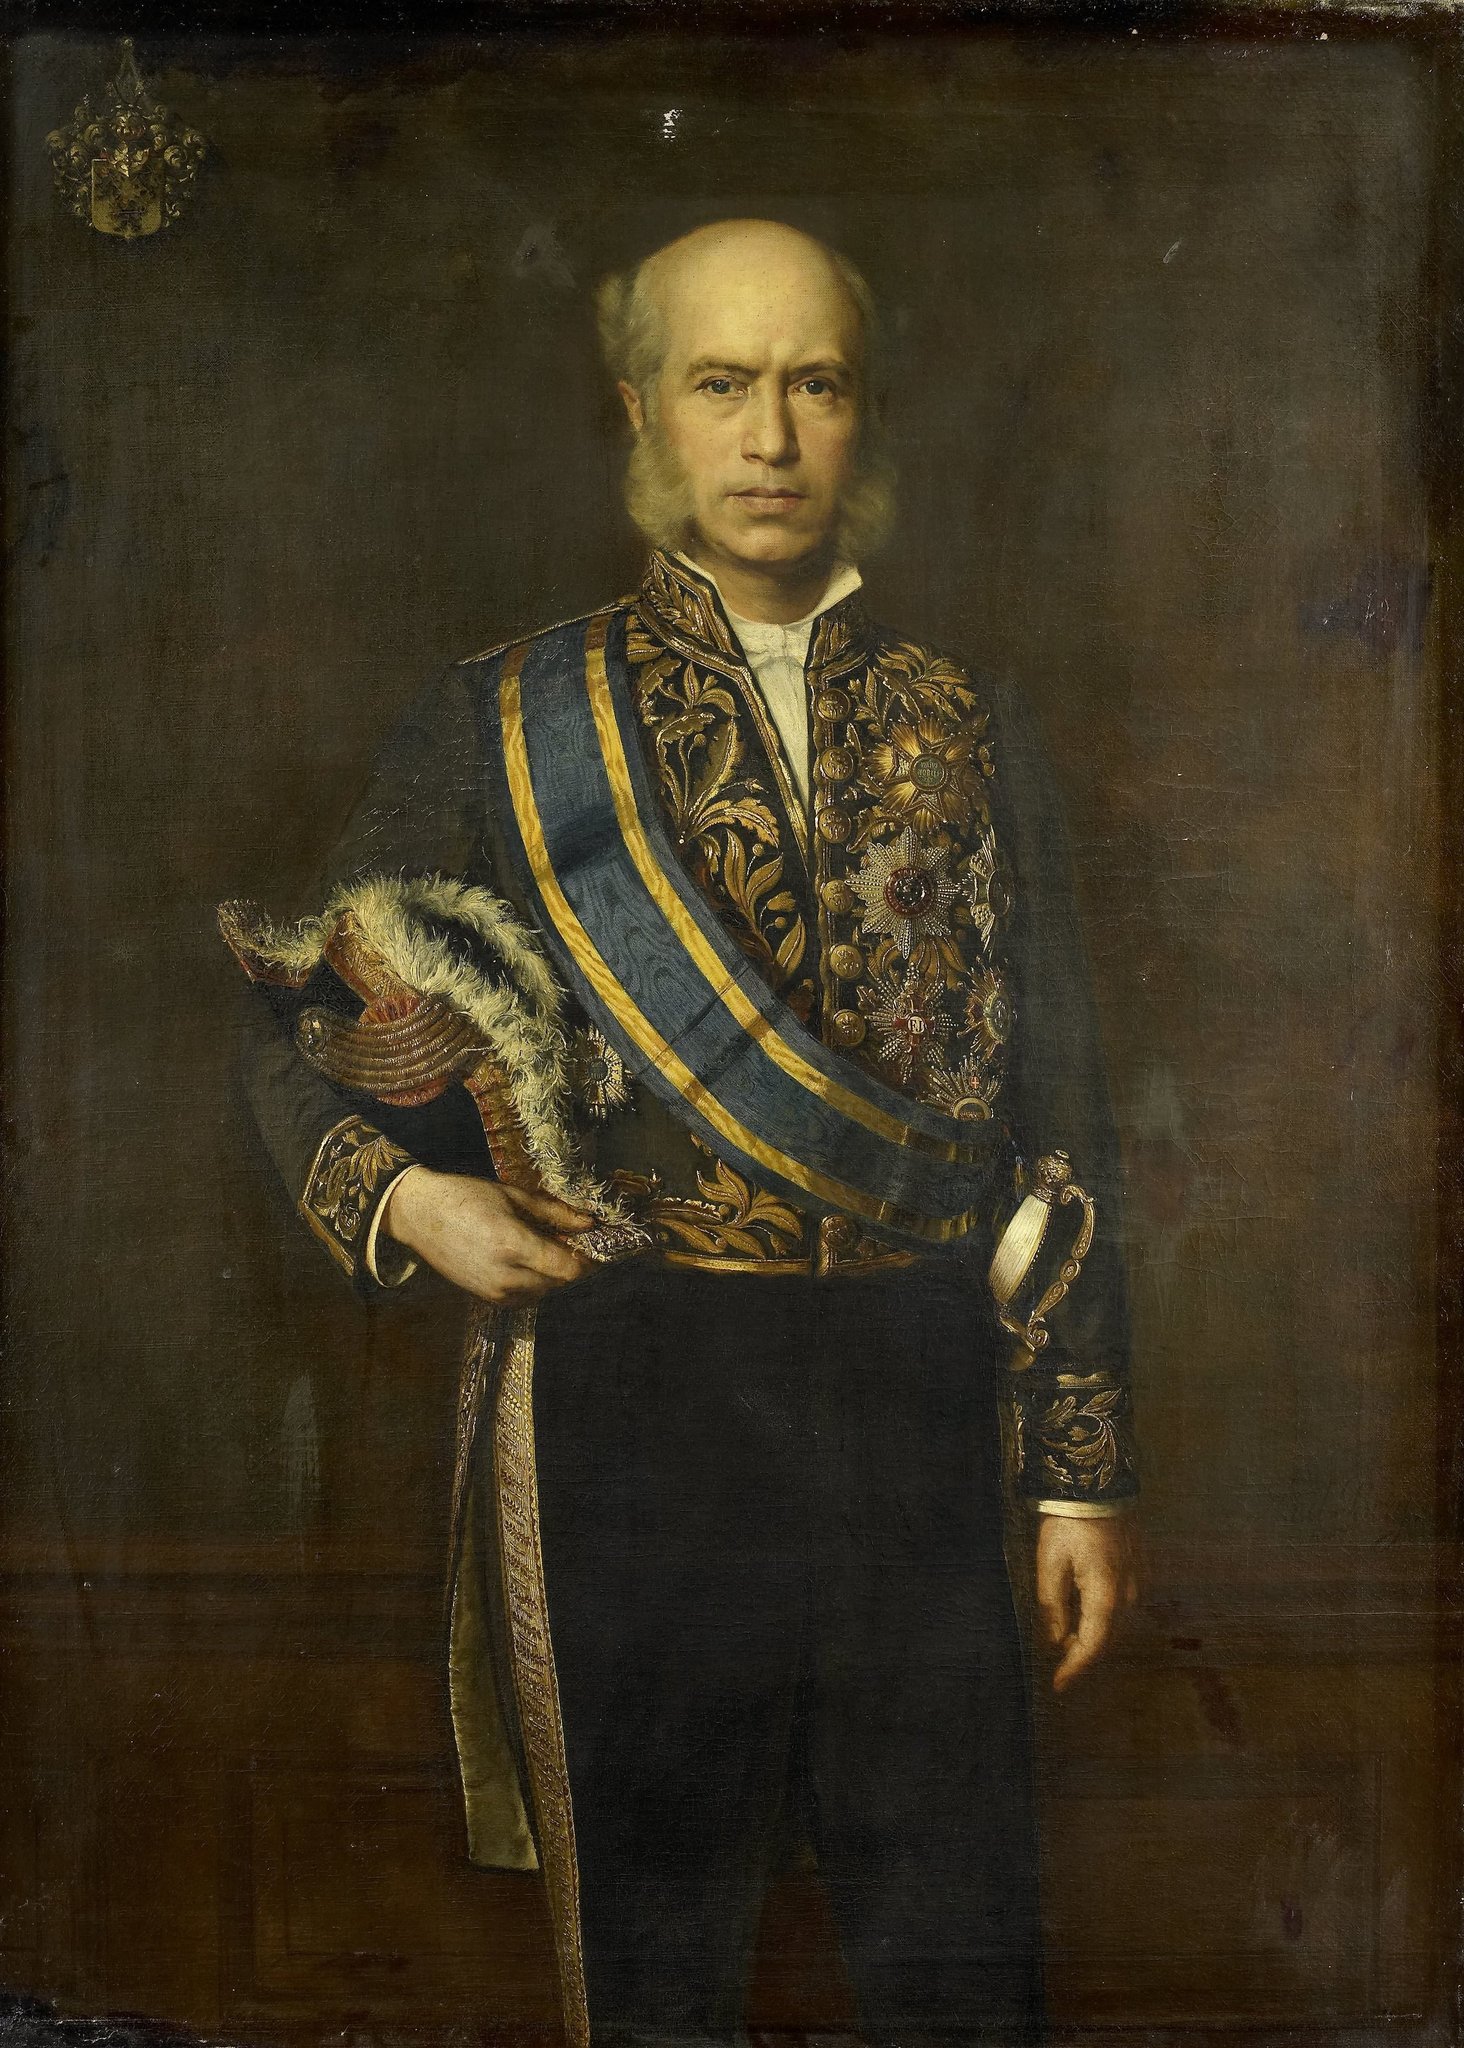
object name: painting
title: Johan Wilhelm van Lansberge (1830-1906). Gouverneur-generaal (1875-1880)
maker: andries van den berg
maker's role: draughtsman, painter, print maker, publisher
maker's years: 1852-1944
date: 1887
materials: canvas, oil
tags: colonial governor, historical persons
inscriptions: signature and date: ‘A. v.d. Berg: 1887’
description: Portret van Johan Wilhelm van Lansberge (1830-1906). Gouverneur-generaal (1875-1880). Kniestuk, staande, en face, met de steek in de rechterarm. Linksboven het familiewapen. Onderdeel van een reeks van portretten van de gouverneurs-generaal van het voormalige Nederlands Oost-Indië.